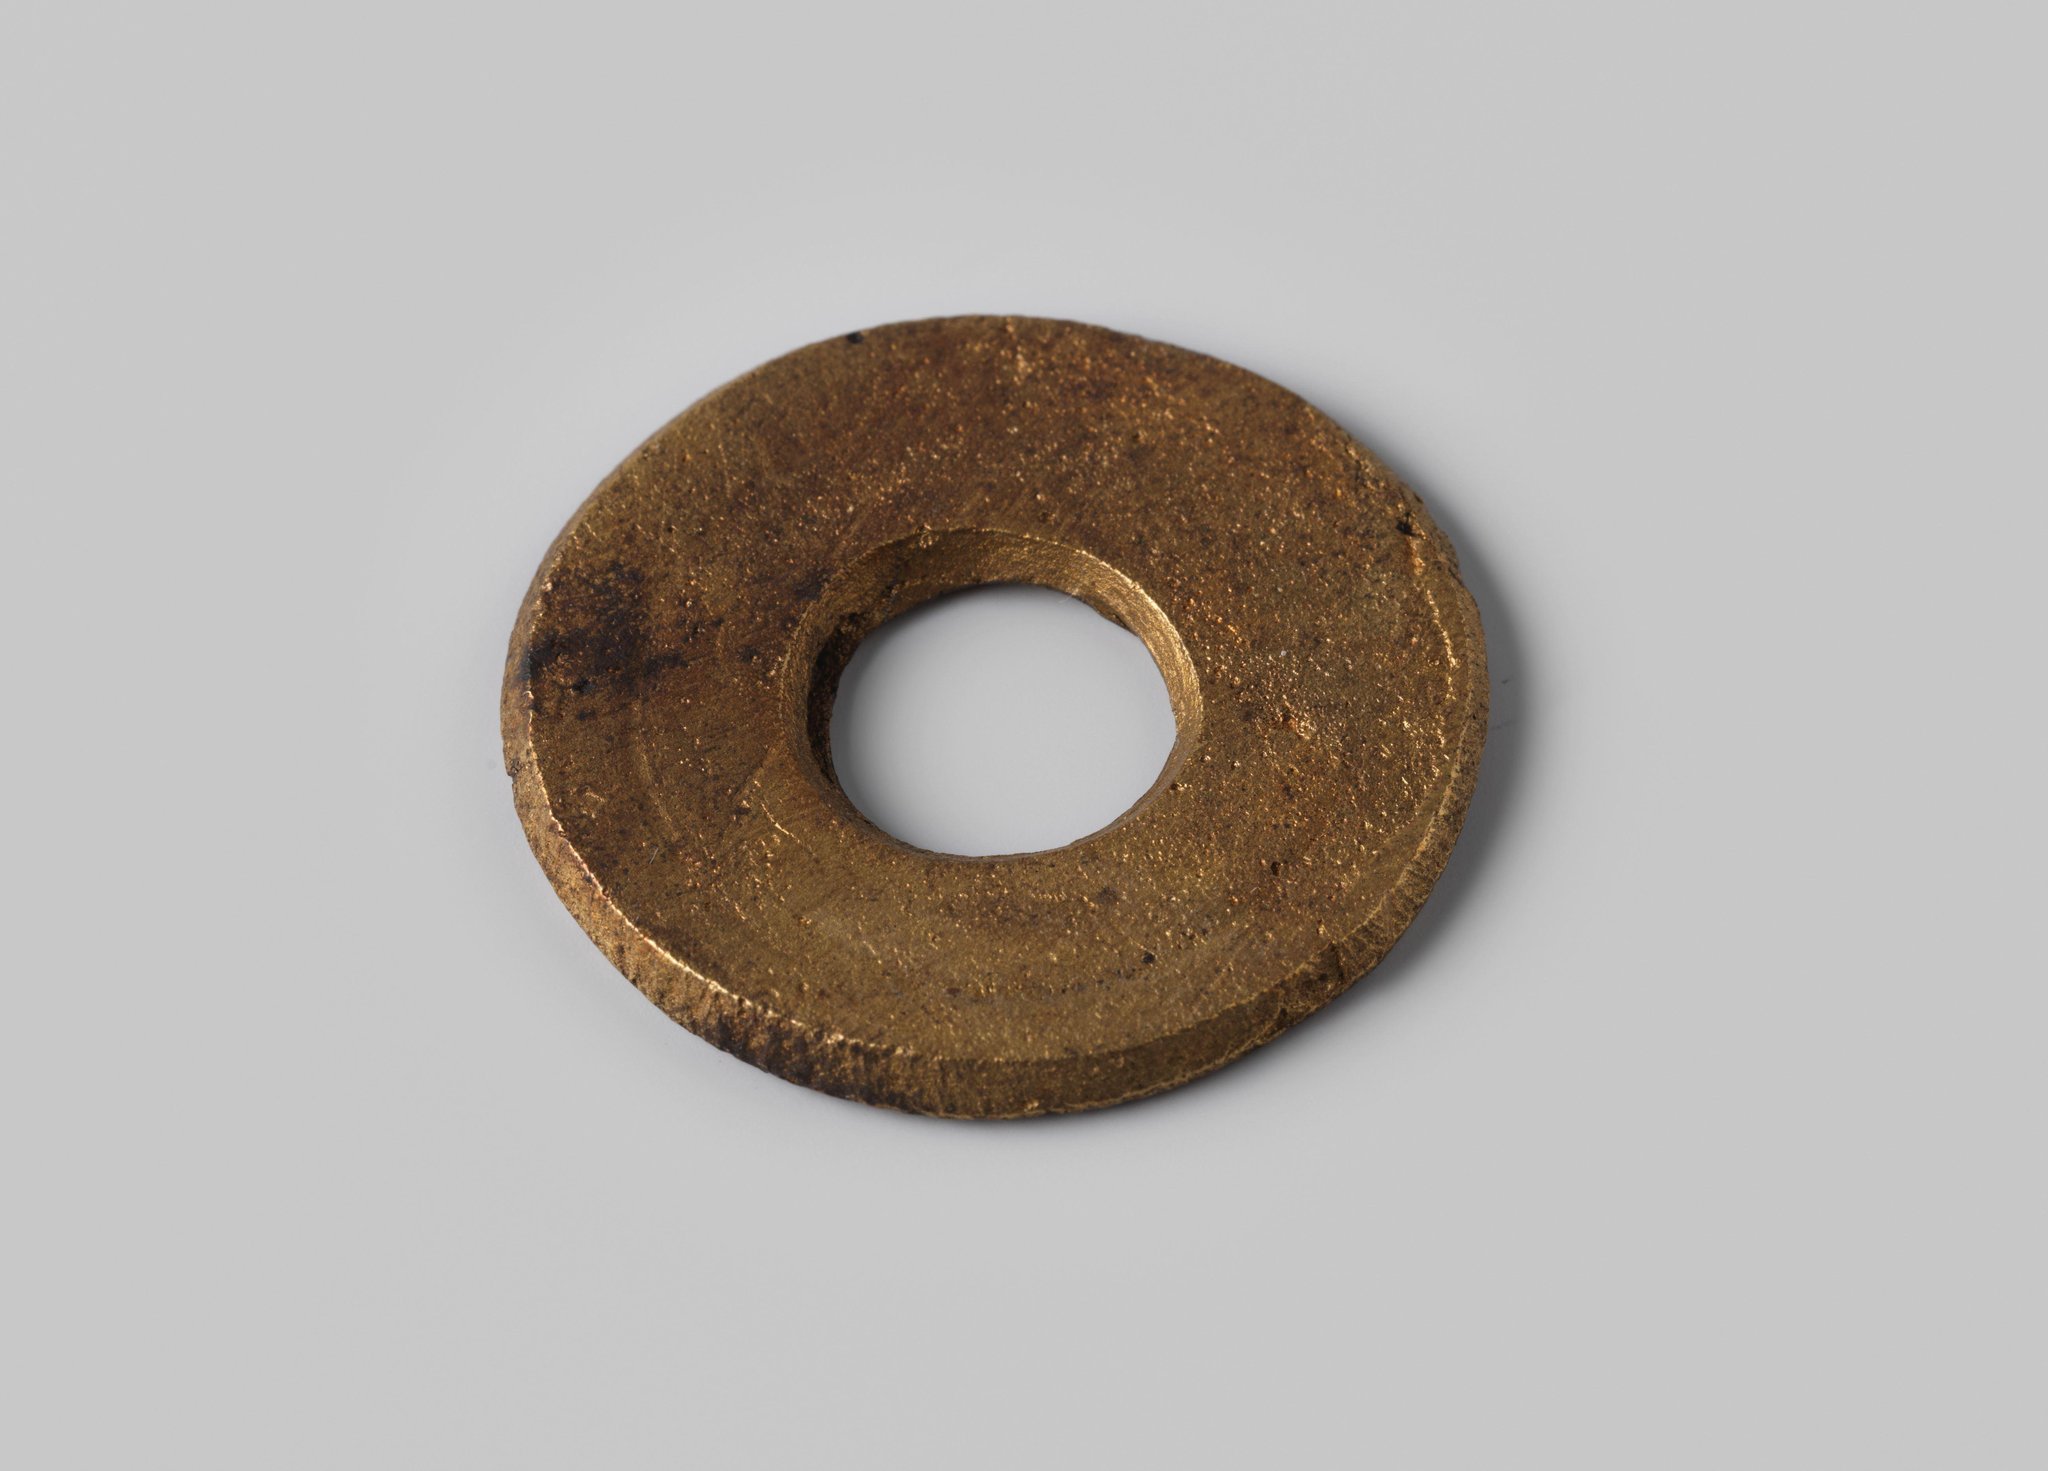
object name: sluitring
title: Sluitring uit het wrak van de Oost-Indiëvaarder Hollandia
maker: Anonymous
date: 1700-1743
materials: copper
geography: netherlands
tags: verenigde oostindische compagnie, hollandia (schip), annet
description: Varied parts or fragments, washers; circular, flat, circular central hole, bevelled inner and outer rim.